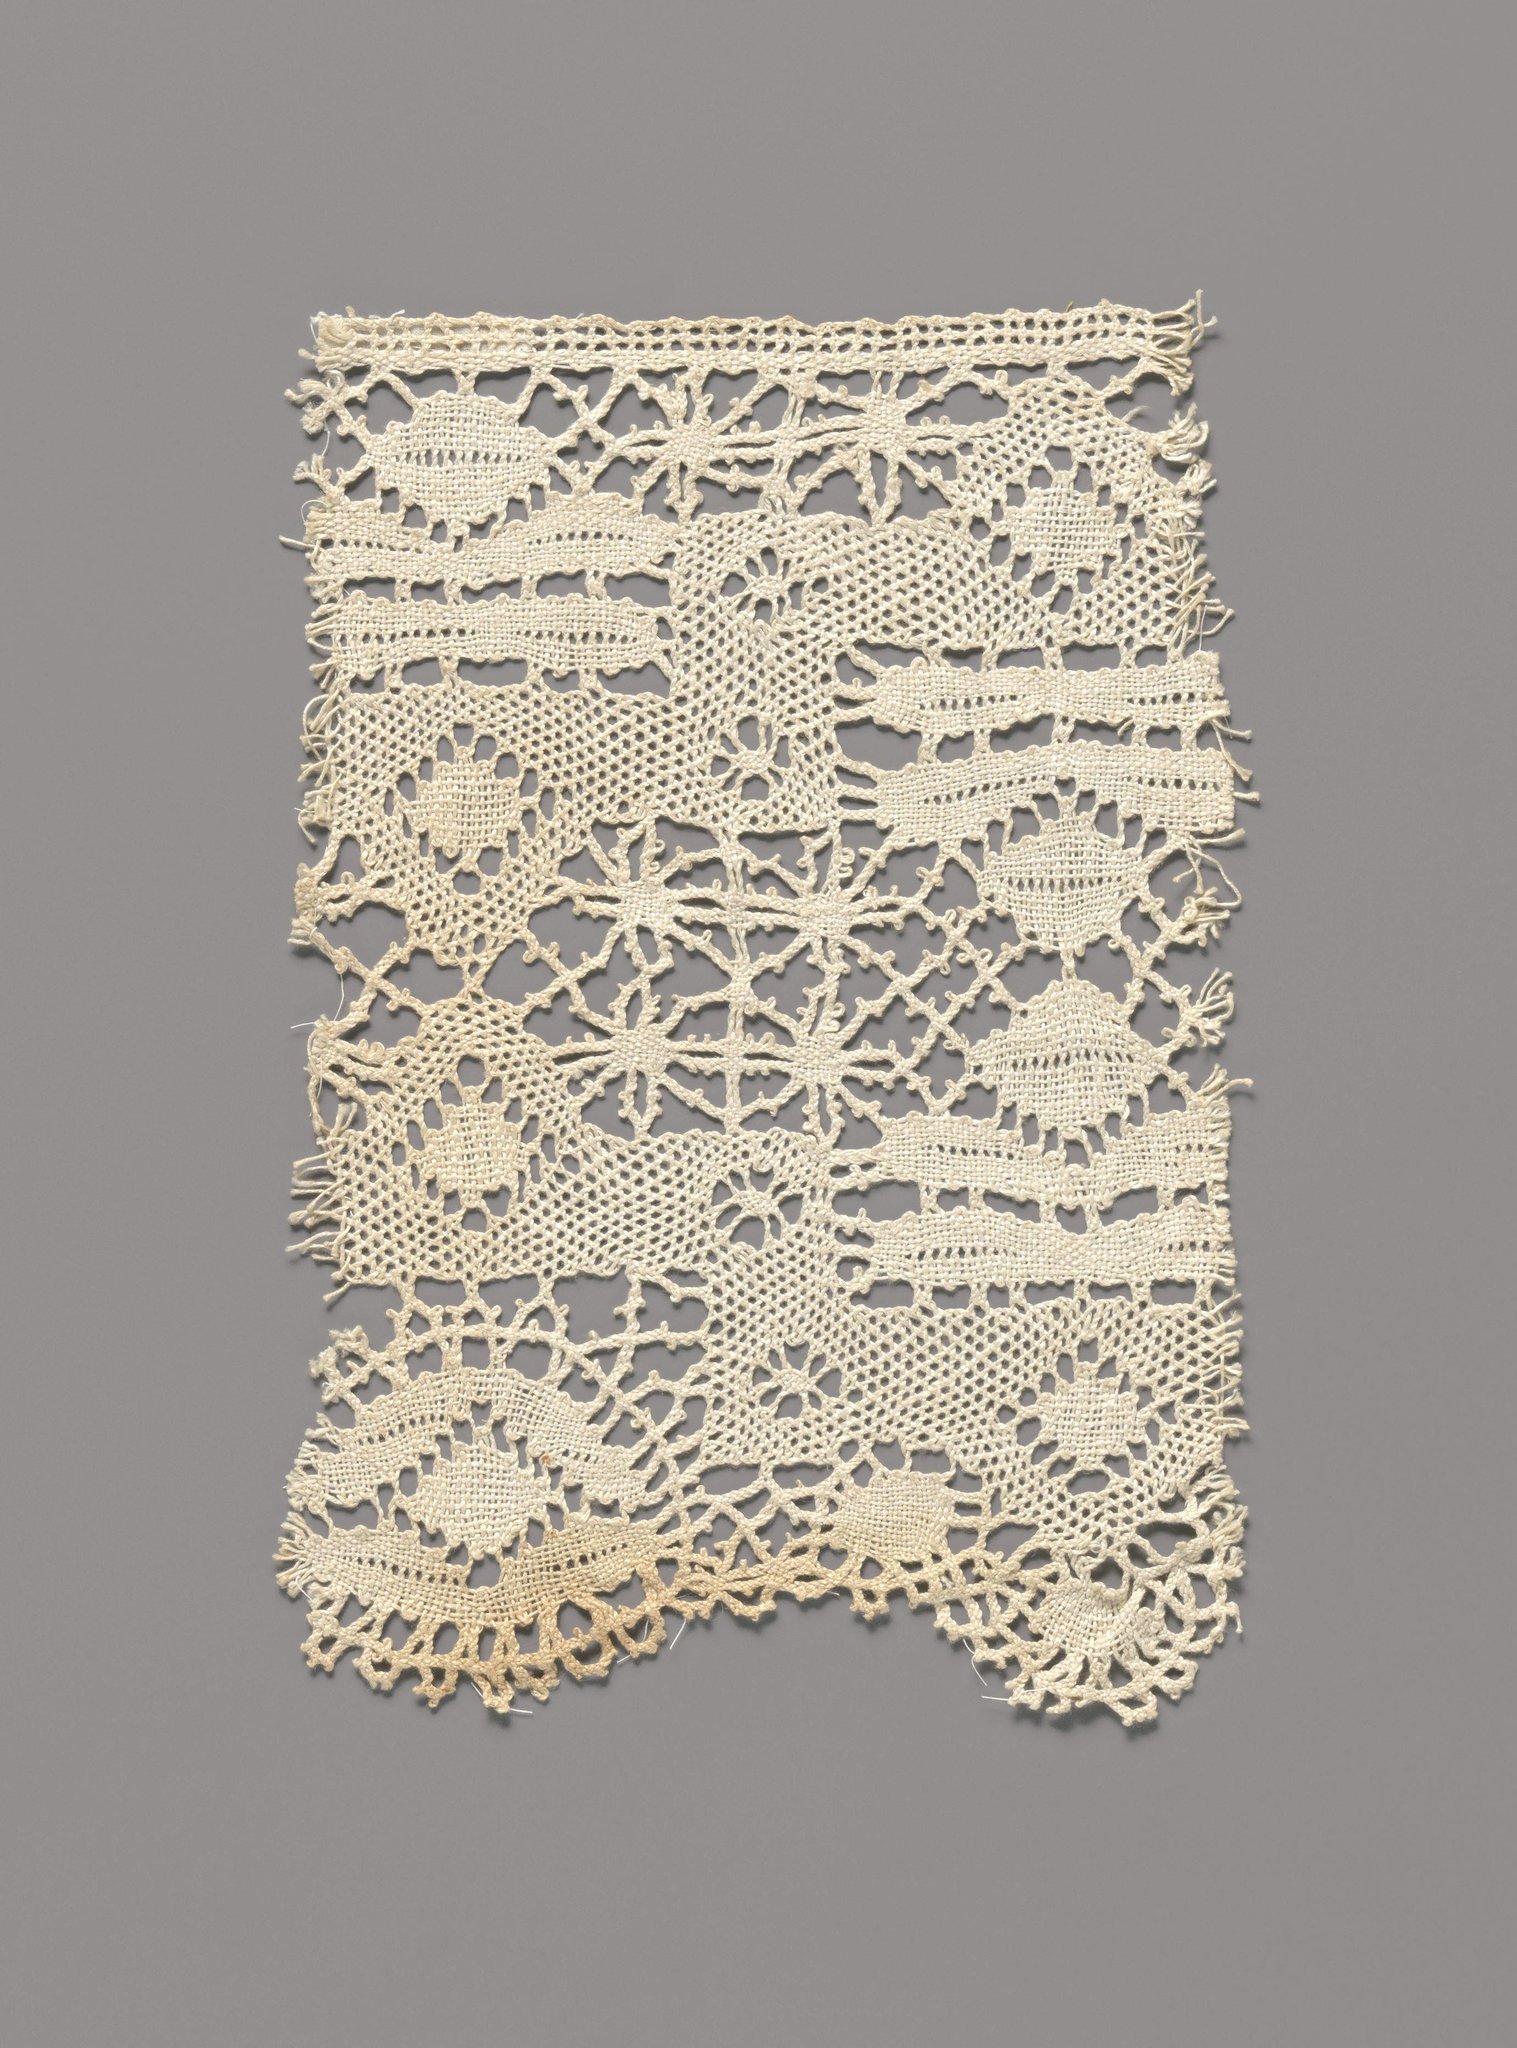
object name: strip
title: Strook kloskant met ruiten en sterren en spinnen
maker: Anonymous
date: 1900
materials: cotton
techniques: lace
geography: bohemia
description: Strook naturelkleurige kloskant: Cluny-kant. Er is gewerkt met dikke draden. In de brede strook zijn in linnenslag en netslag verschillende ruiten, sterren en spinnen gemaakt. De motieven zijn met elkaar verbonden door gepicoteerde vlechten. De bovenzijde van de strook is recht afgewerkt. De twee ongelijke schulpen langs de onderzijde zijn voorzien van lobjes, gemaakt met gepicoteerde vlechten.